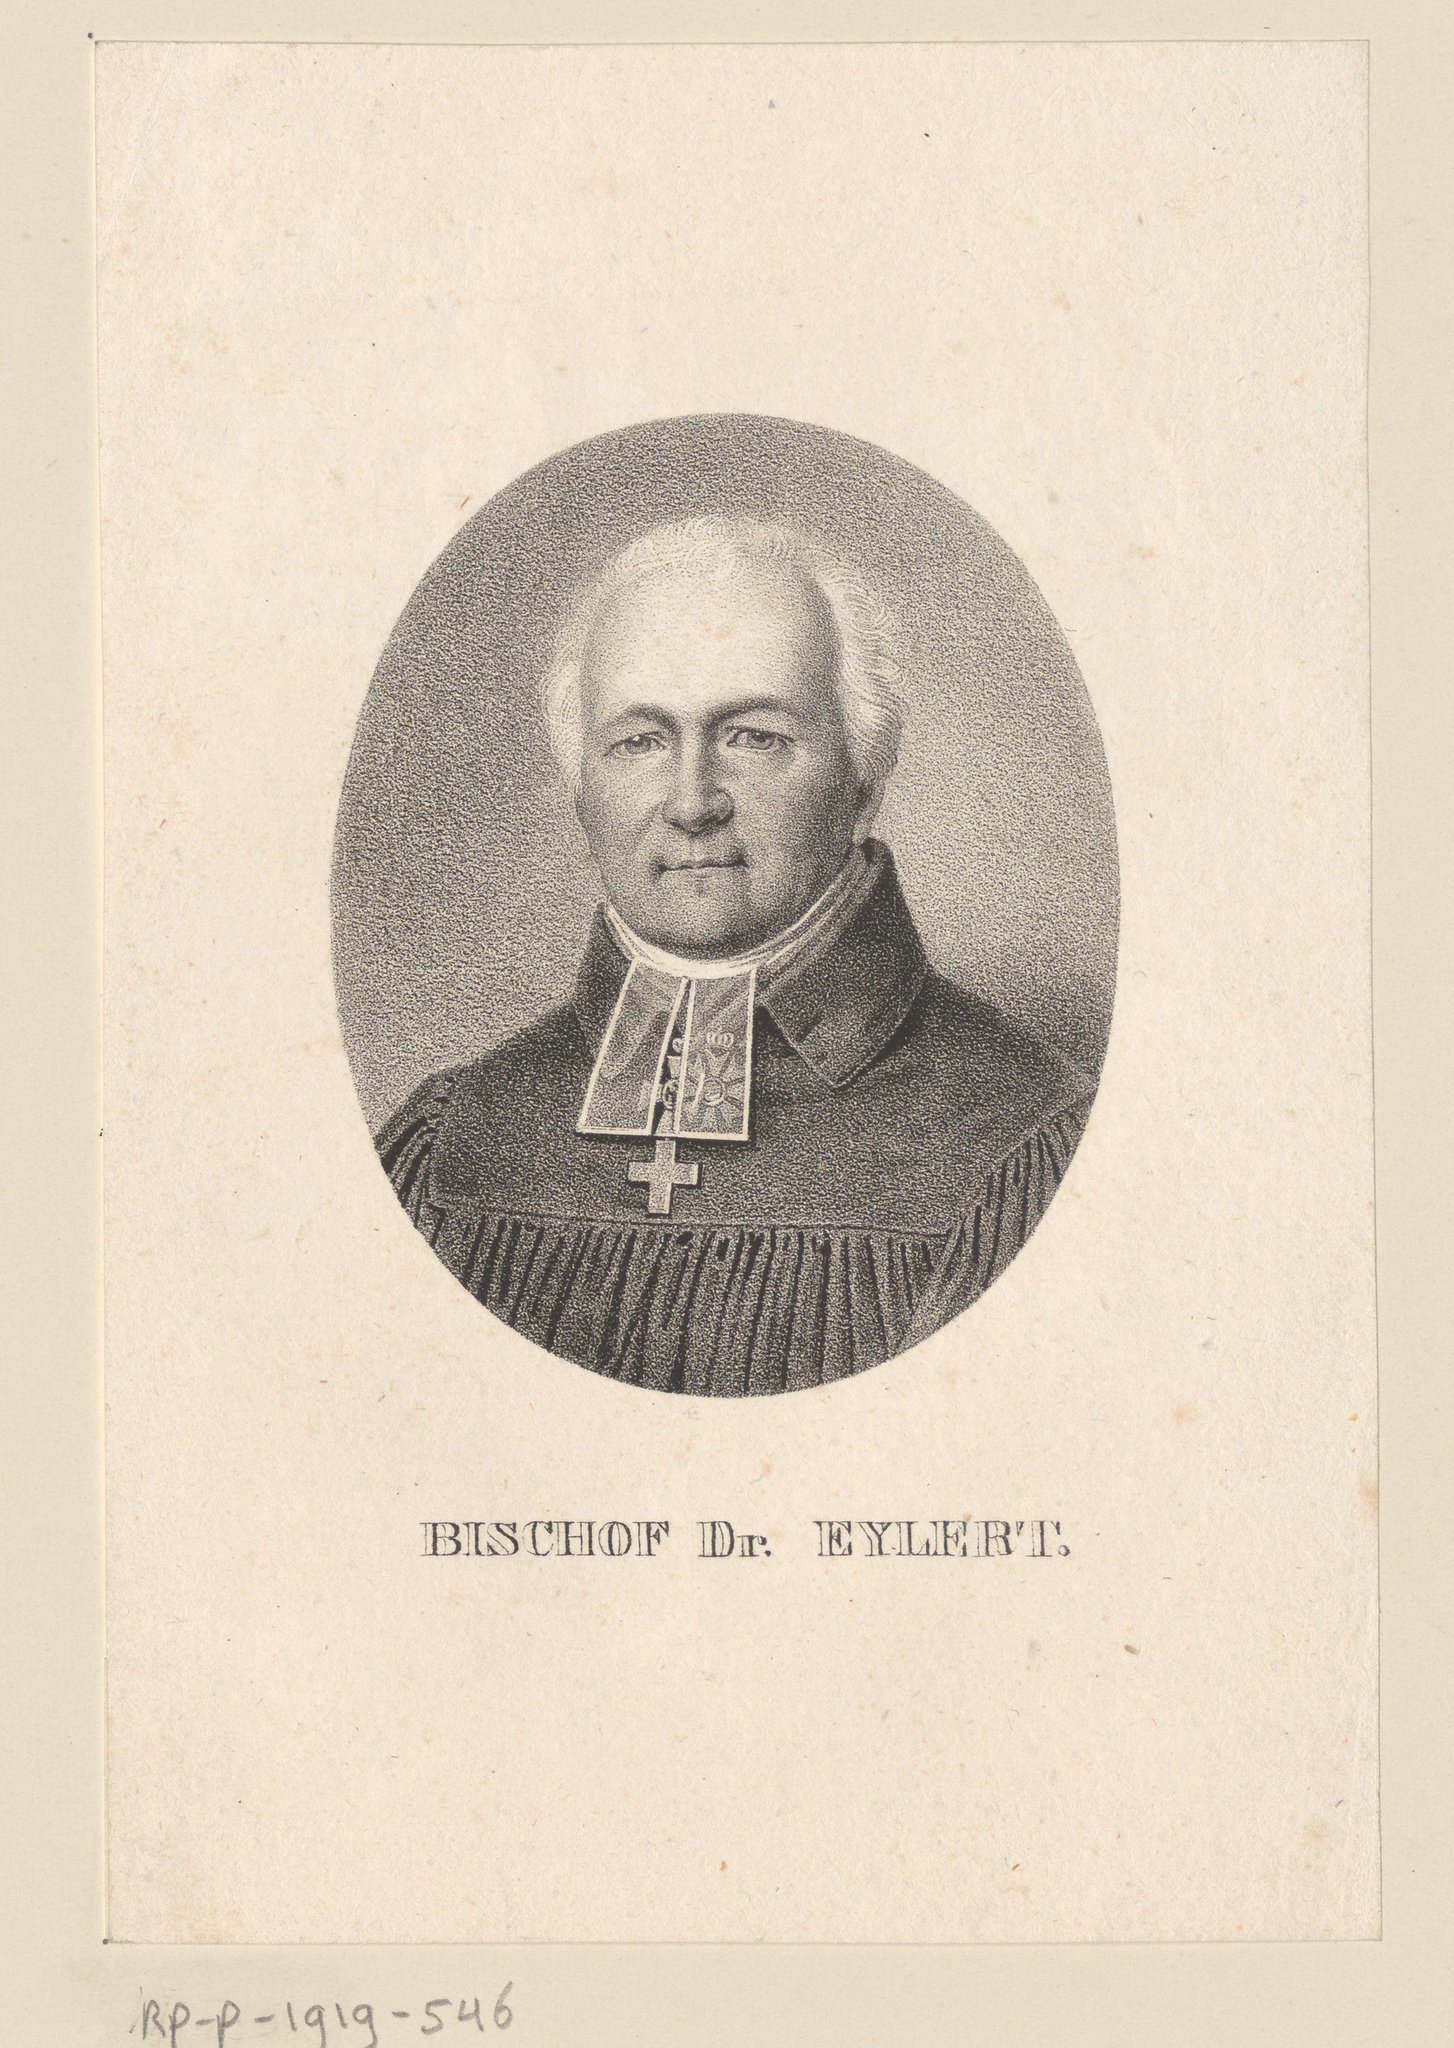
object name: print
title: Portret van Rulemann Friedrich Eylert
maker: Anonymous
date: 1810-1860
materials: paper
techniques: lithograph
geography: germany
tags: historical persons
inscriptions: collector's mark: Lugt 2228